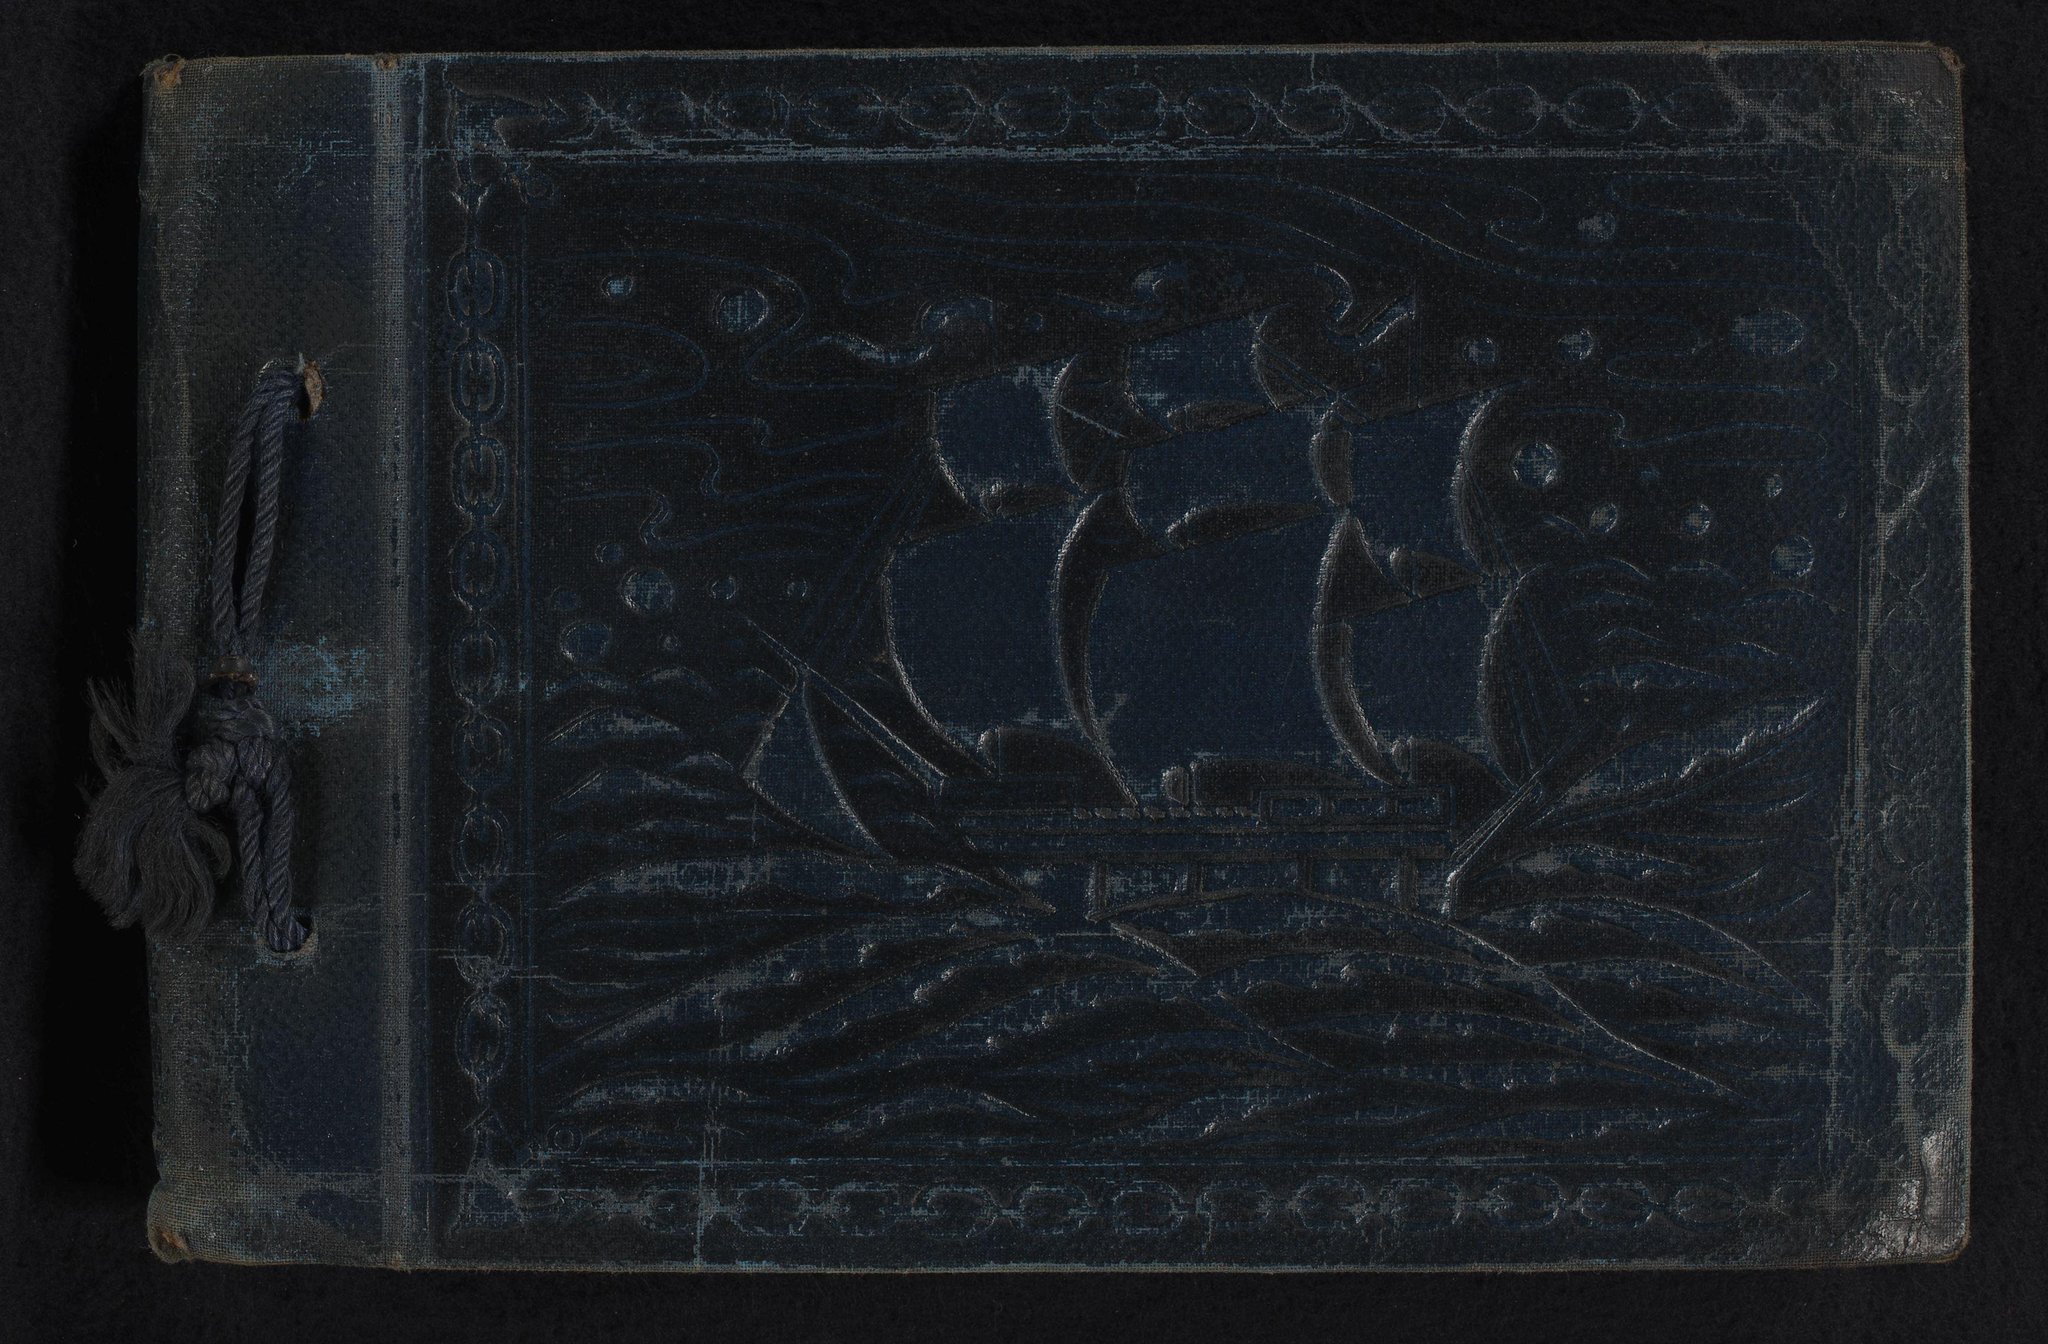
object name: scrapbook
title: Fotoalbum Amsterdamse poppendokter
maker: Anonymous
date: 1930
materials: cardboard, leather, photographic support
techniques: gelatin silver print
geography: netherlands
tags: advertising, dolls for adults, dog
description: Album met 61 foto's. Het album bevat foto's en krantenknipsels over "de Poppendokter" en zijn honden.